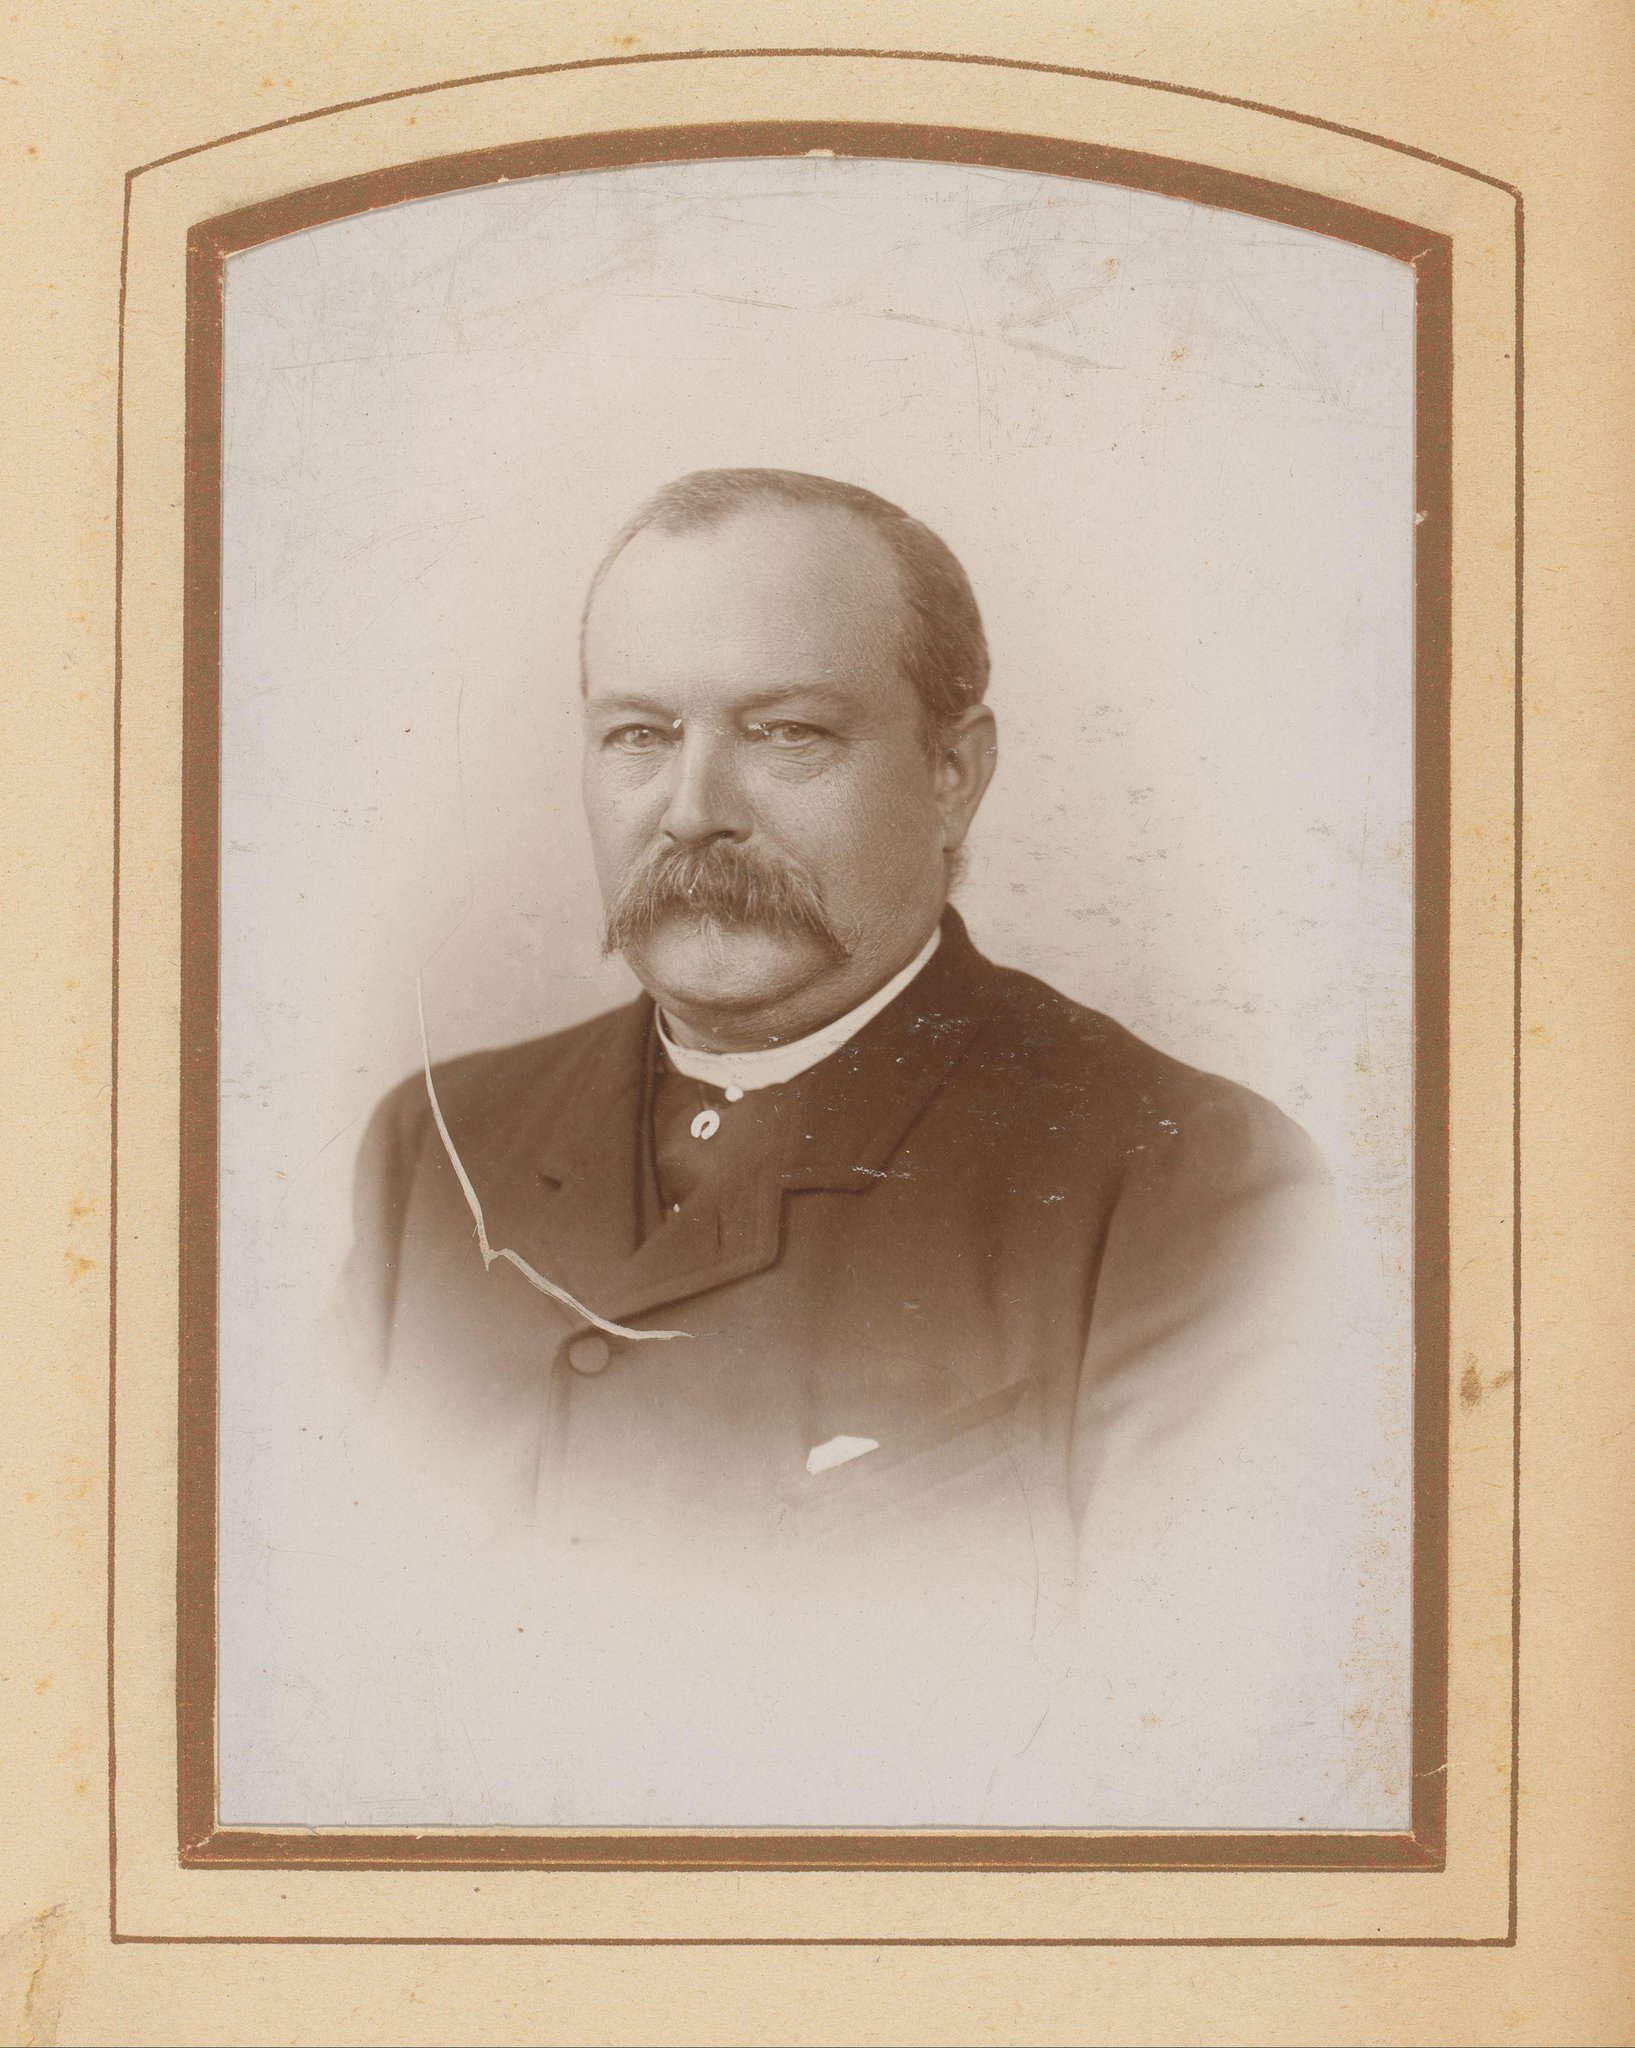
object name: album leaf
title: Portret van een man met snor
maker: hendrik jonker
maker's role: fotograaf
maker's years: 1846-1932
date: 1882-1914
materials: cardboard, photographic support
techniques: collodion silver print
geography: leiden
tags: moustache, historical persons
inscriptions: inscription: ‘H. Jonker/ Leiden/ Apothekersdijk No 7’, annotation: ‘AV’